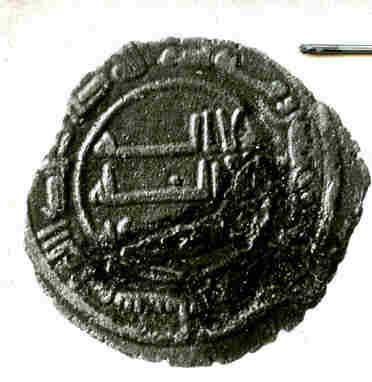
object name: coin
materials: copper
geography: iran